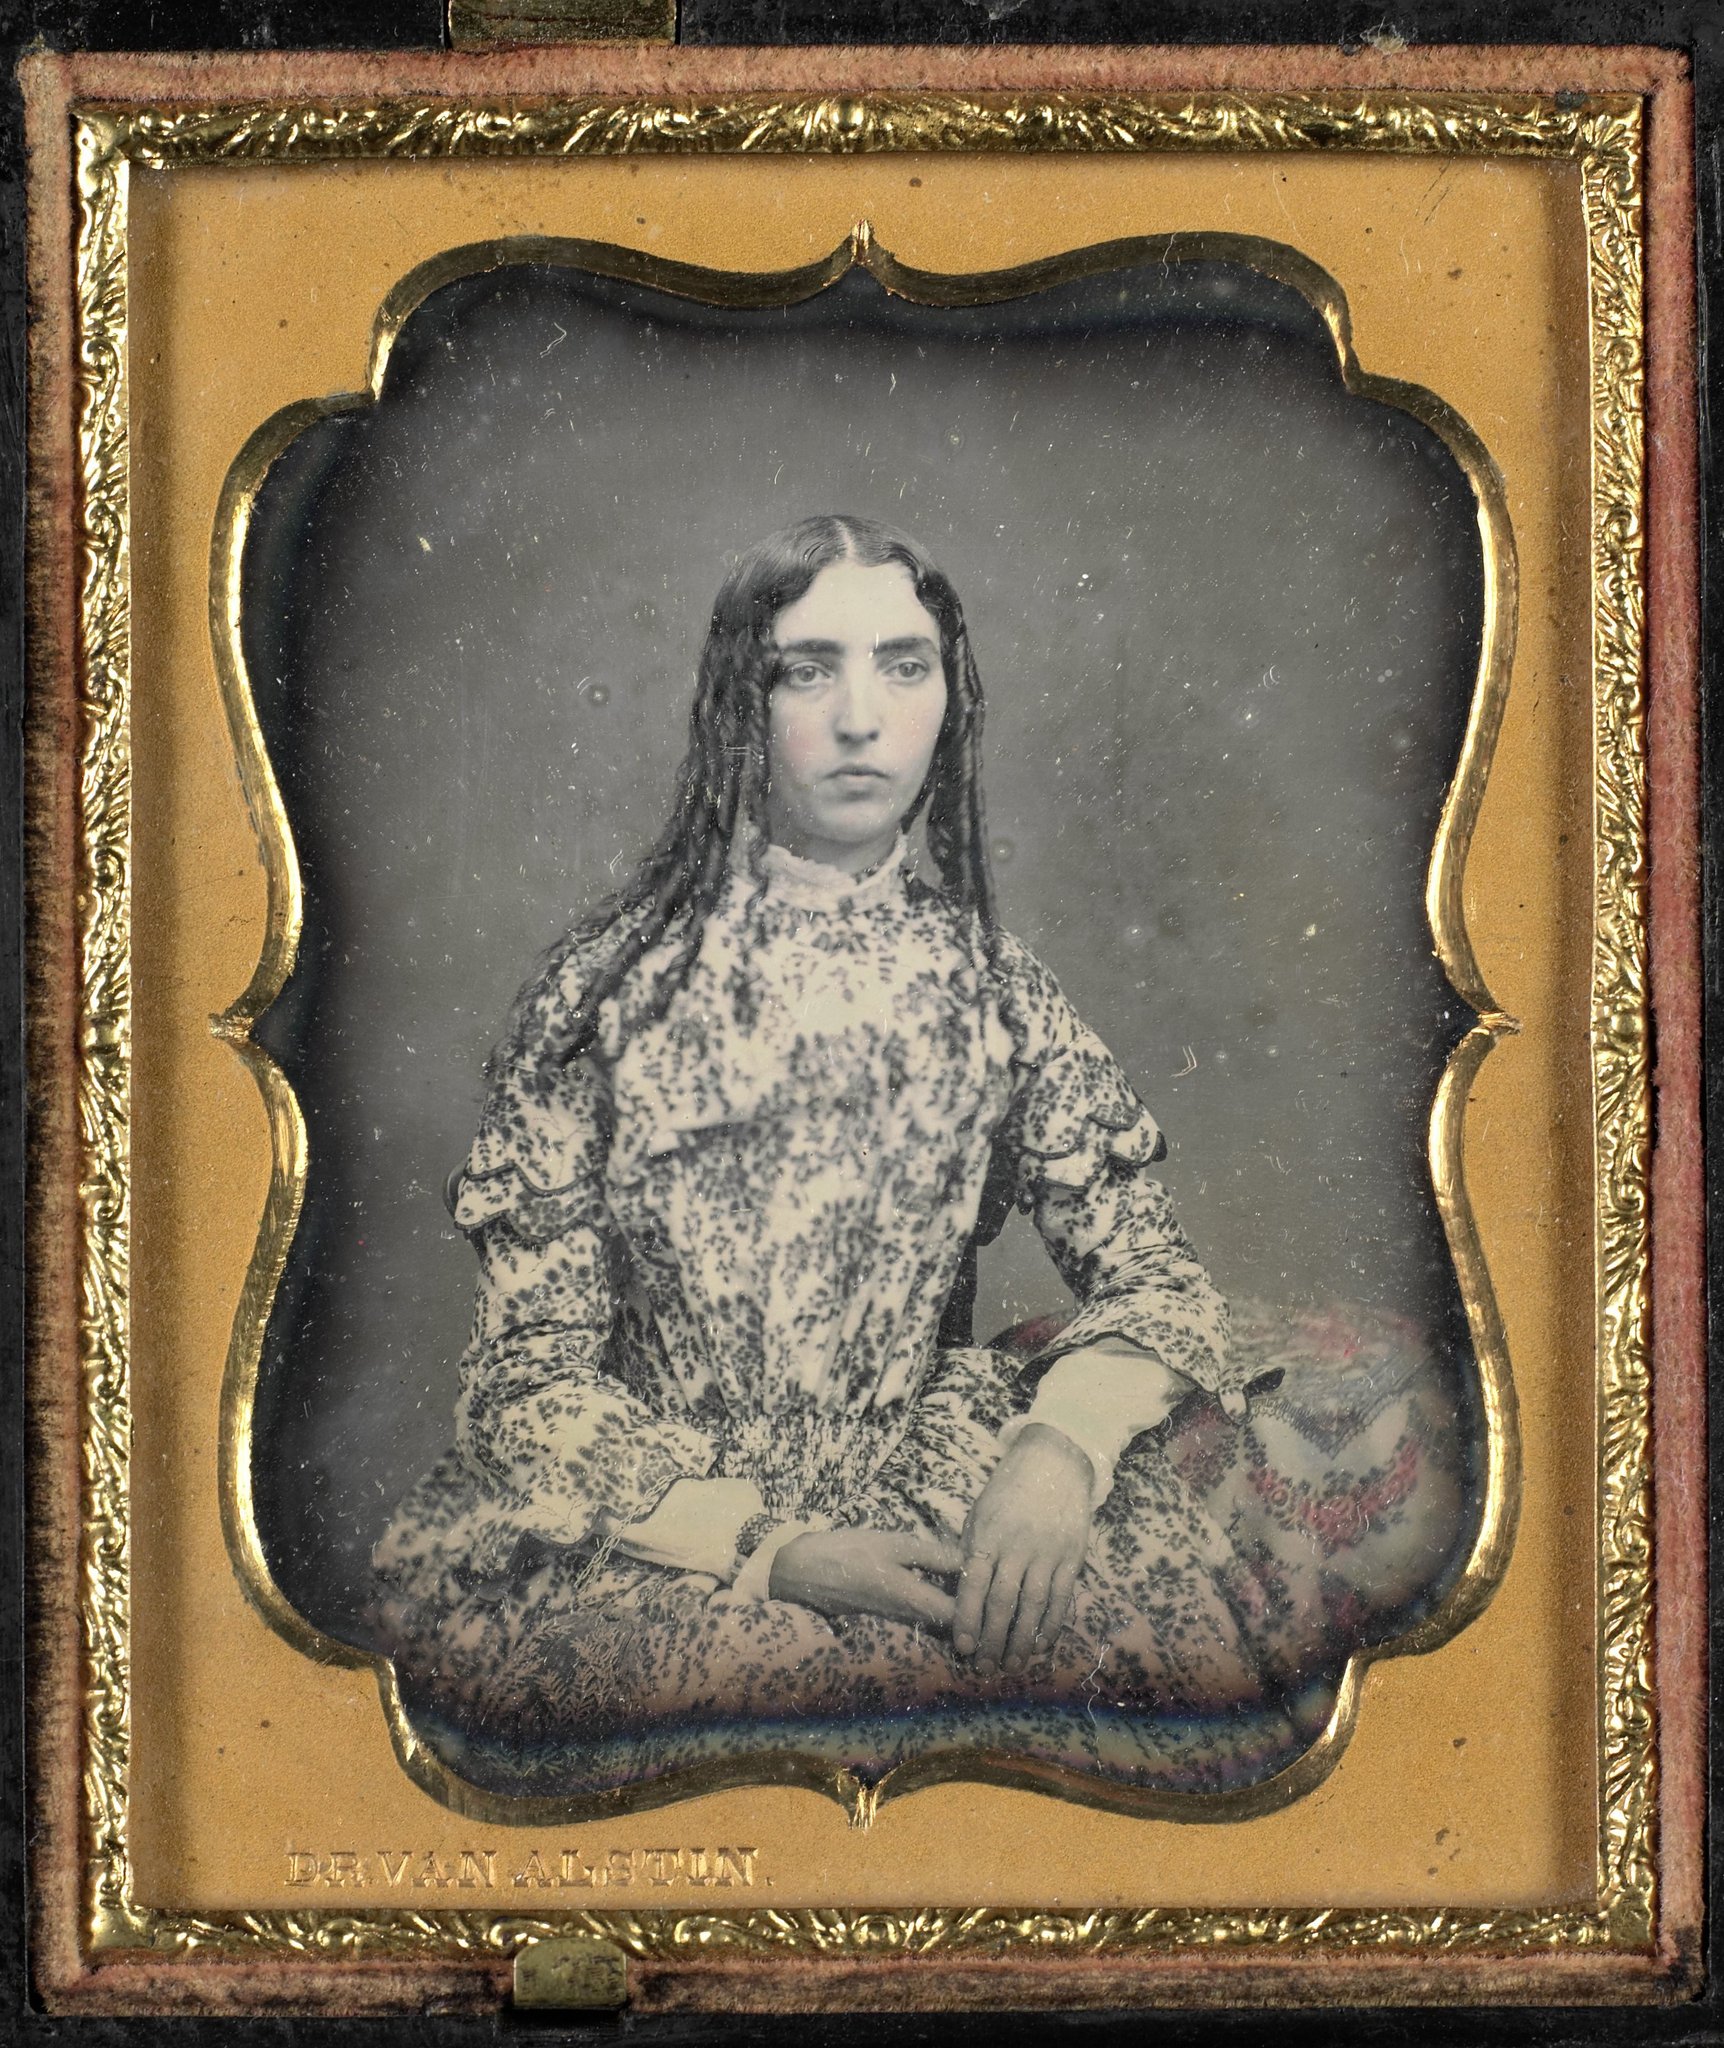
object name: photograph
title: Portret van een onbekende jonge vrouw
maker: andrew wemple van alstin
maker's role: fotograaf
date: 1840-1860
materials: copper, glass, plastic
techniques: daguerreotype, hand coloring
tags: adolescent, young woman, maiden, historical persons